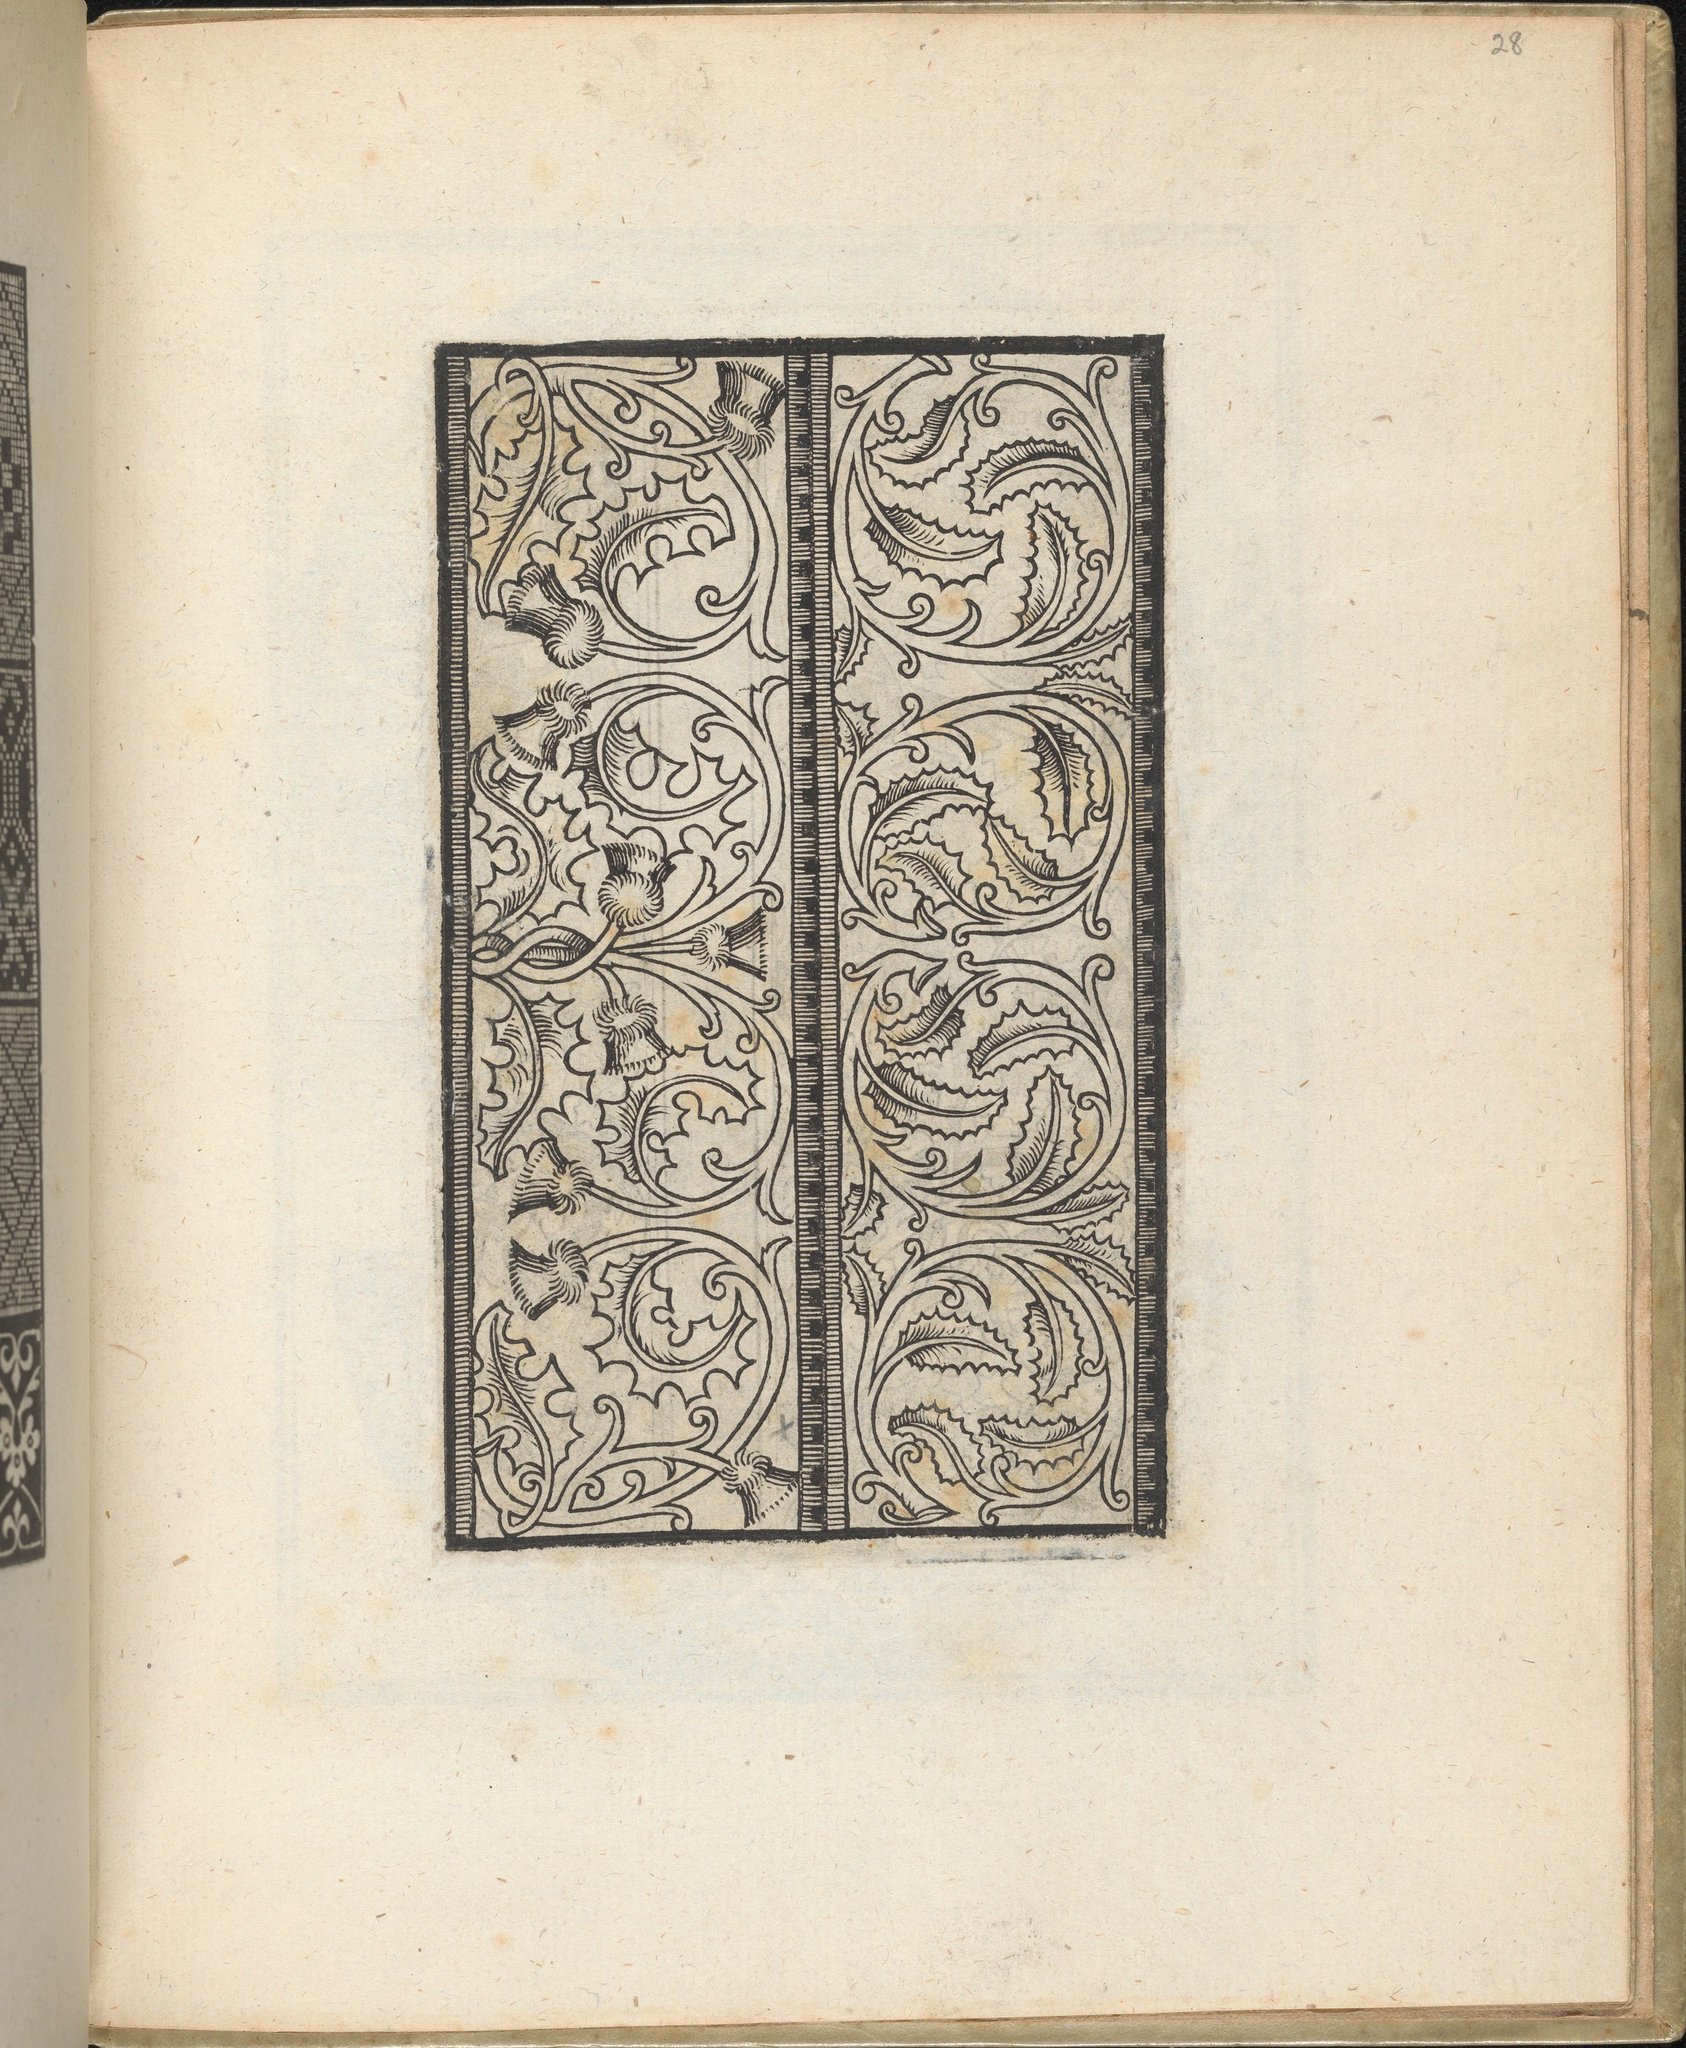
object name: book print ornament architecture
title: Trionfo Di Virtu. Libro Novo..., page 28 (verso)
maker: matteo pagano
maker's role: publisher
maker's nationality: italian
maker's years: 1515-1588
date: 1563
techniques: woodcut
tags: ornament